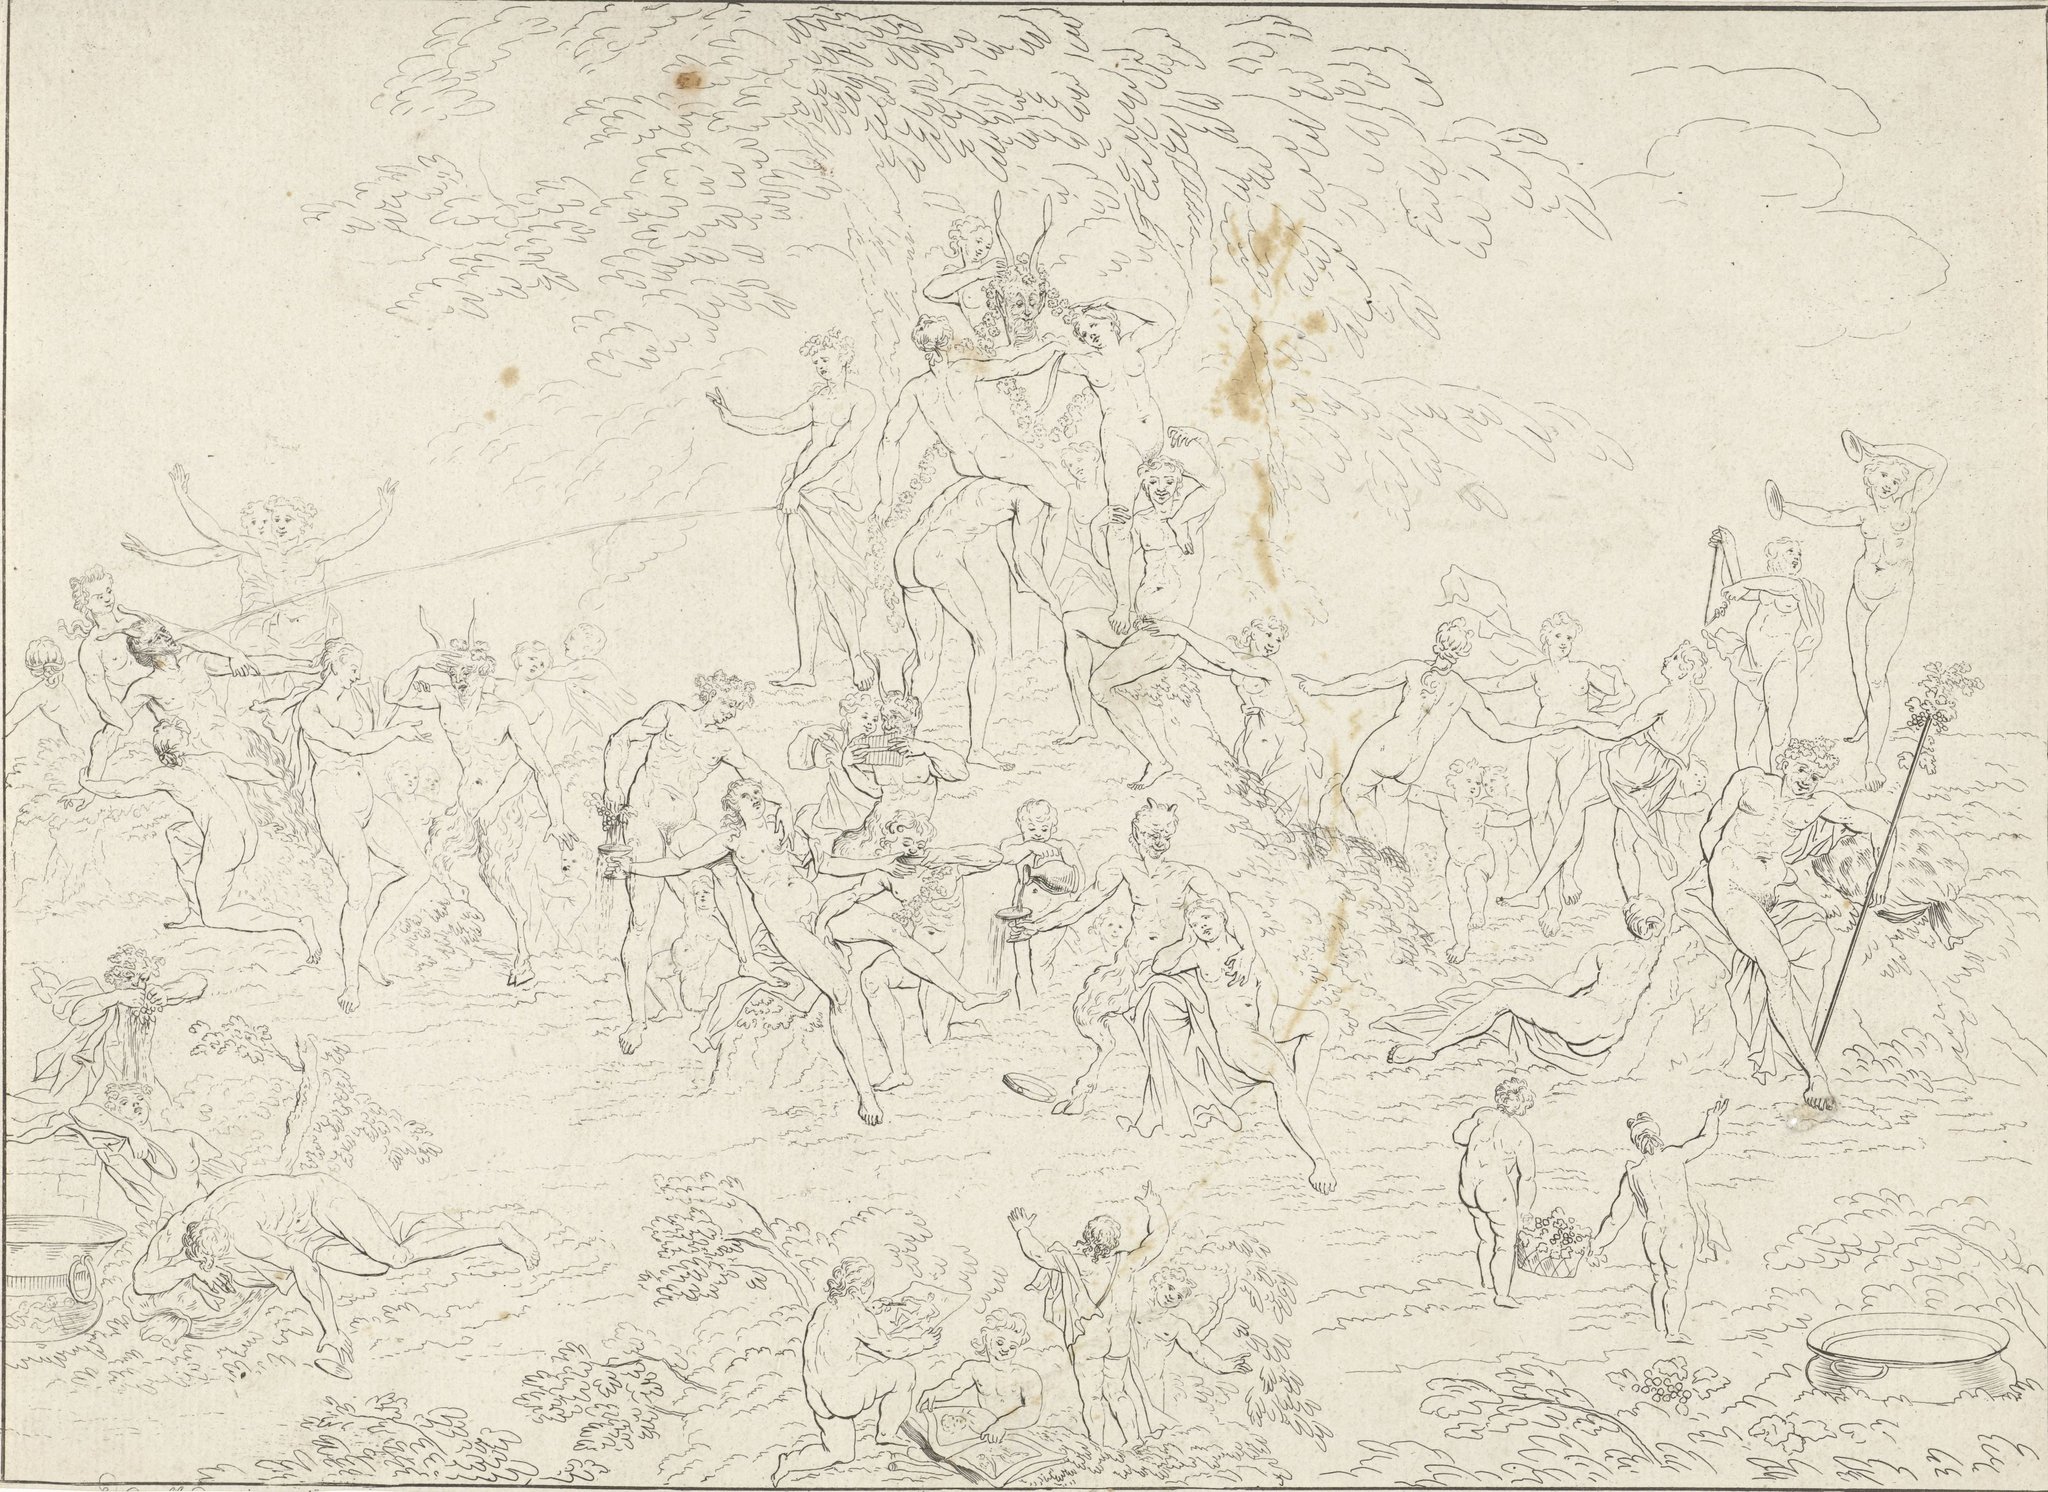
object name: print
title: Het leven der Bacchanten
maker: gerard melder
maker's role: painter, print maker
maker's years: 1693-1754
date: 1725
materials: paper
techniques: etching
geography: amsterdam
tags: bacchanal: bacchus with his wine-flushed train (thiasos), male bacchant(es), thiasos, i.e. bacchus' revel-rout, bacchanal without bacchus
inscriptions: collector's mark: Lugt 2228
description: Een saterbeeld wordt door nimfen met bloemguirlandes versiert. Om het hoofd te kunnen bereiken zitten de nimfen op de schouders van bacchanten. Rond om het beeld vindt een bacchanaal met wijn en muziek plaats. Links pist een bacchant een sater in de mond.